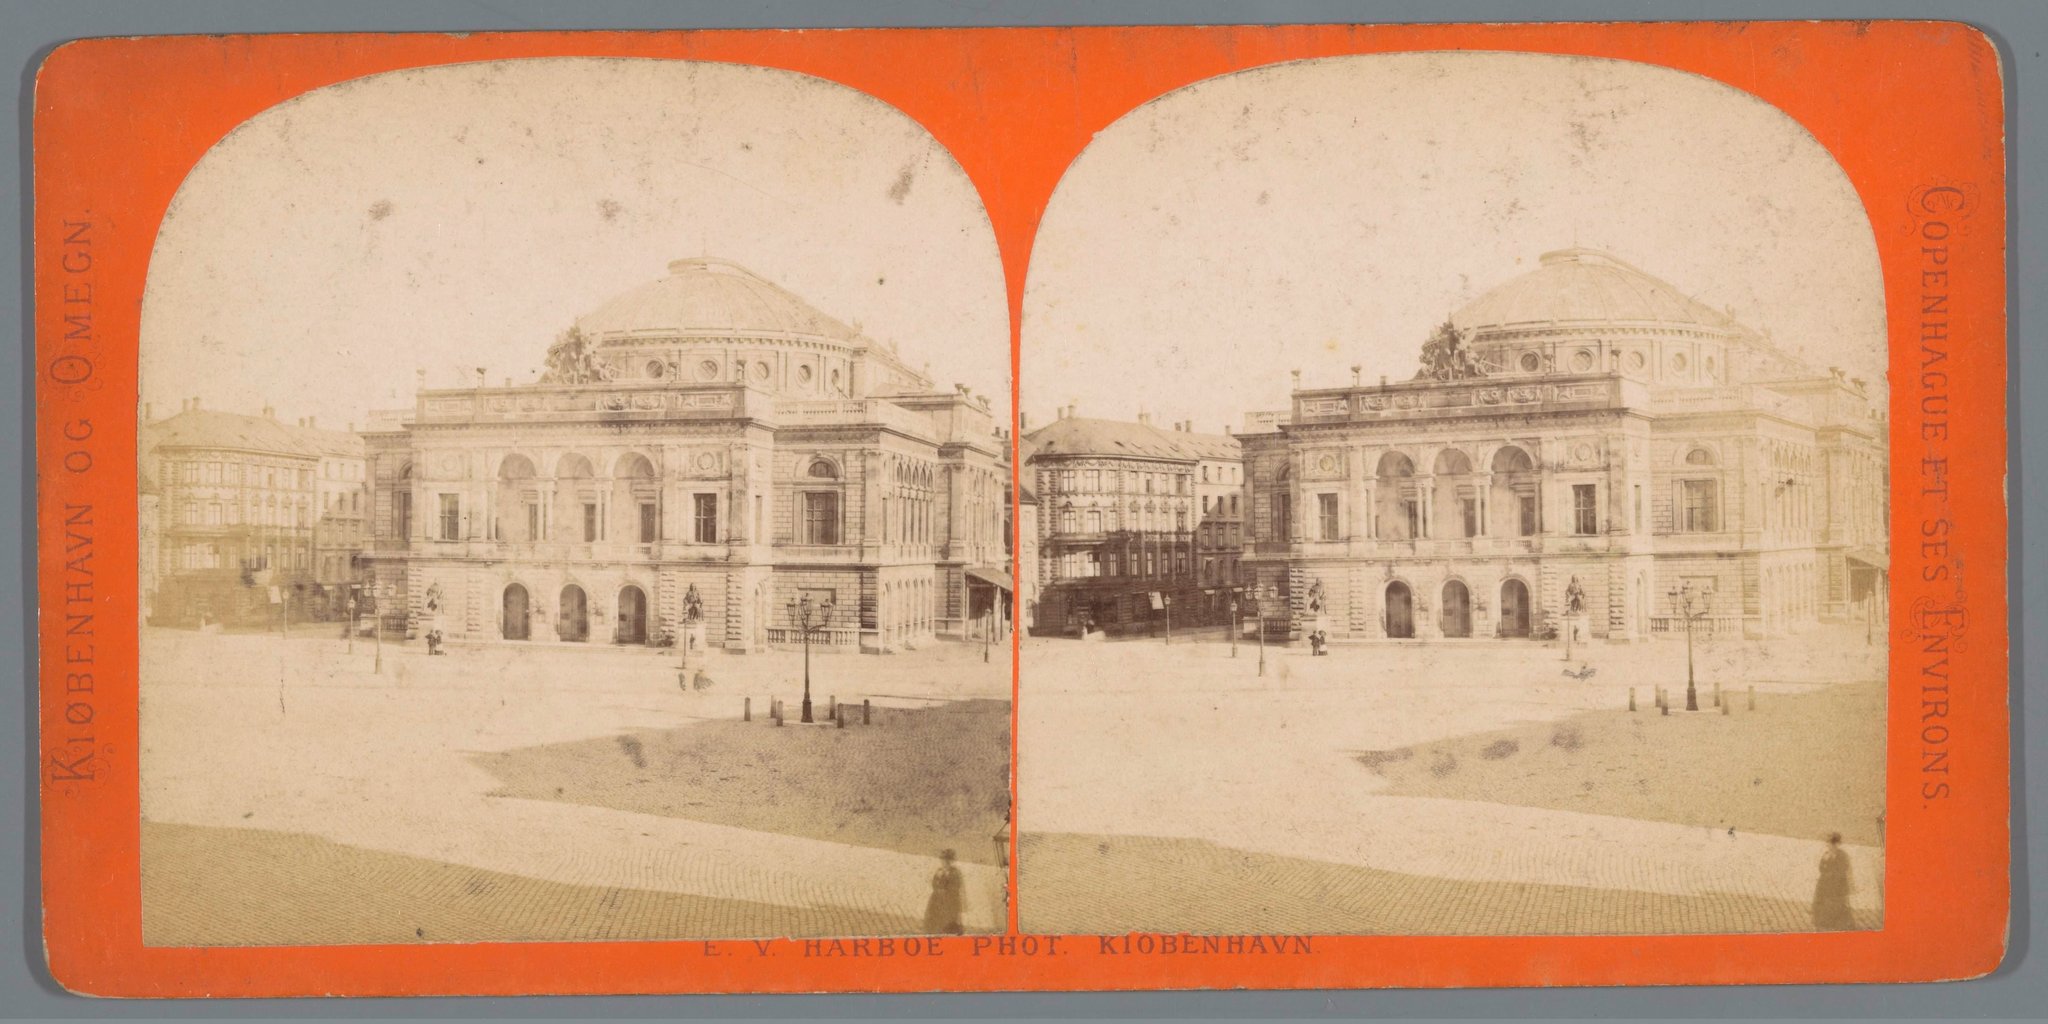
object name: stereograph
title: Kiøbenhavn og omegn / Copenhague et ses environs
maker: edvard valdemar harboe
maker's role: fotograaf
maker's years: 1834-1883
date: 1874-1883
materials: cardboard, paper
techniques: albumen print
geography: copenhagen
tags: theatre (building)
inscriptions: inscription: ‘A’